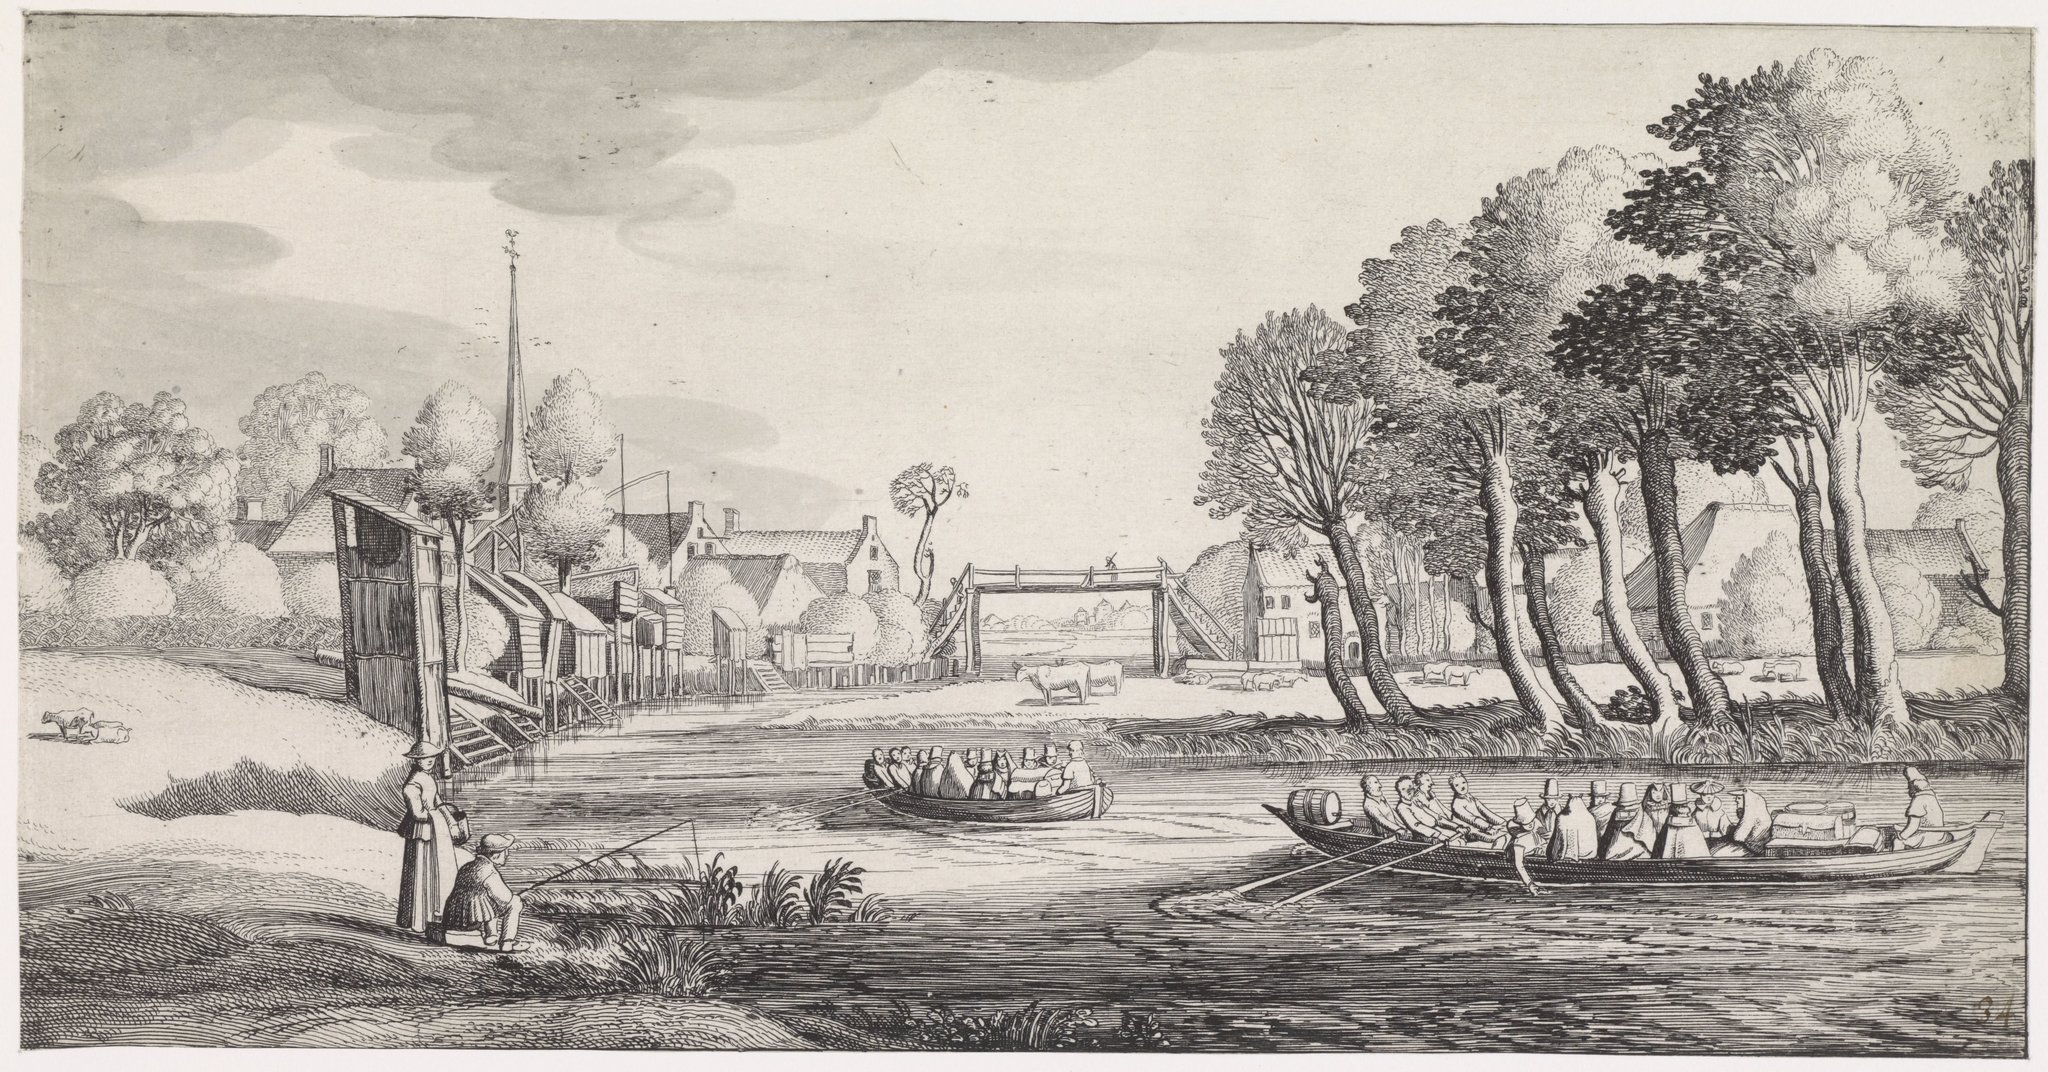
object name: print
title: Playsante lantschappen ende vermakelycke gesichten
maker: jan van de velde (ii)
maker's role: draughtsman, painter, print maker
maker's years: 1593-1641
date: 1639-1641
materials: ink, paper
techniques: brush, etching, pen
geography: northern netherlands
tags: river, landscape with bridge, viaduct or aqueduct, rowing facing backward, pulling, bridge in city across river, canal, etc., 'en route', traveller under way, angling, prospect of city, town panorama, silhouette of city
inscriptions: number: ‘34’, collector's mark: Lugt 2228, collector's mark: Lugt 1120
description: Op een rivier worden reizigers vervoerd in grote roeiboten. Zij naderen een dorp. Links een hengelaar en in het midden een brug. 34ste prent van een serie met 36 prenten van landschappen, verdeeld over zes delen.